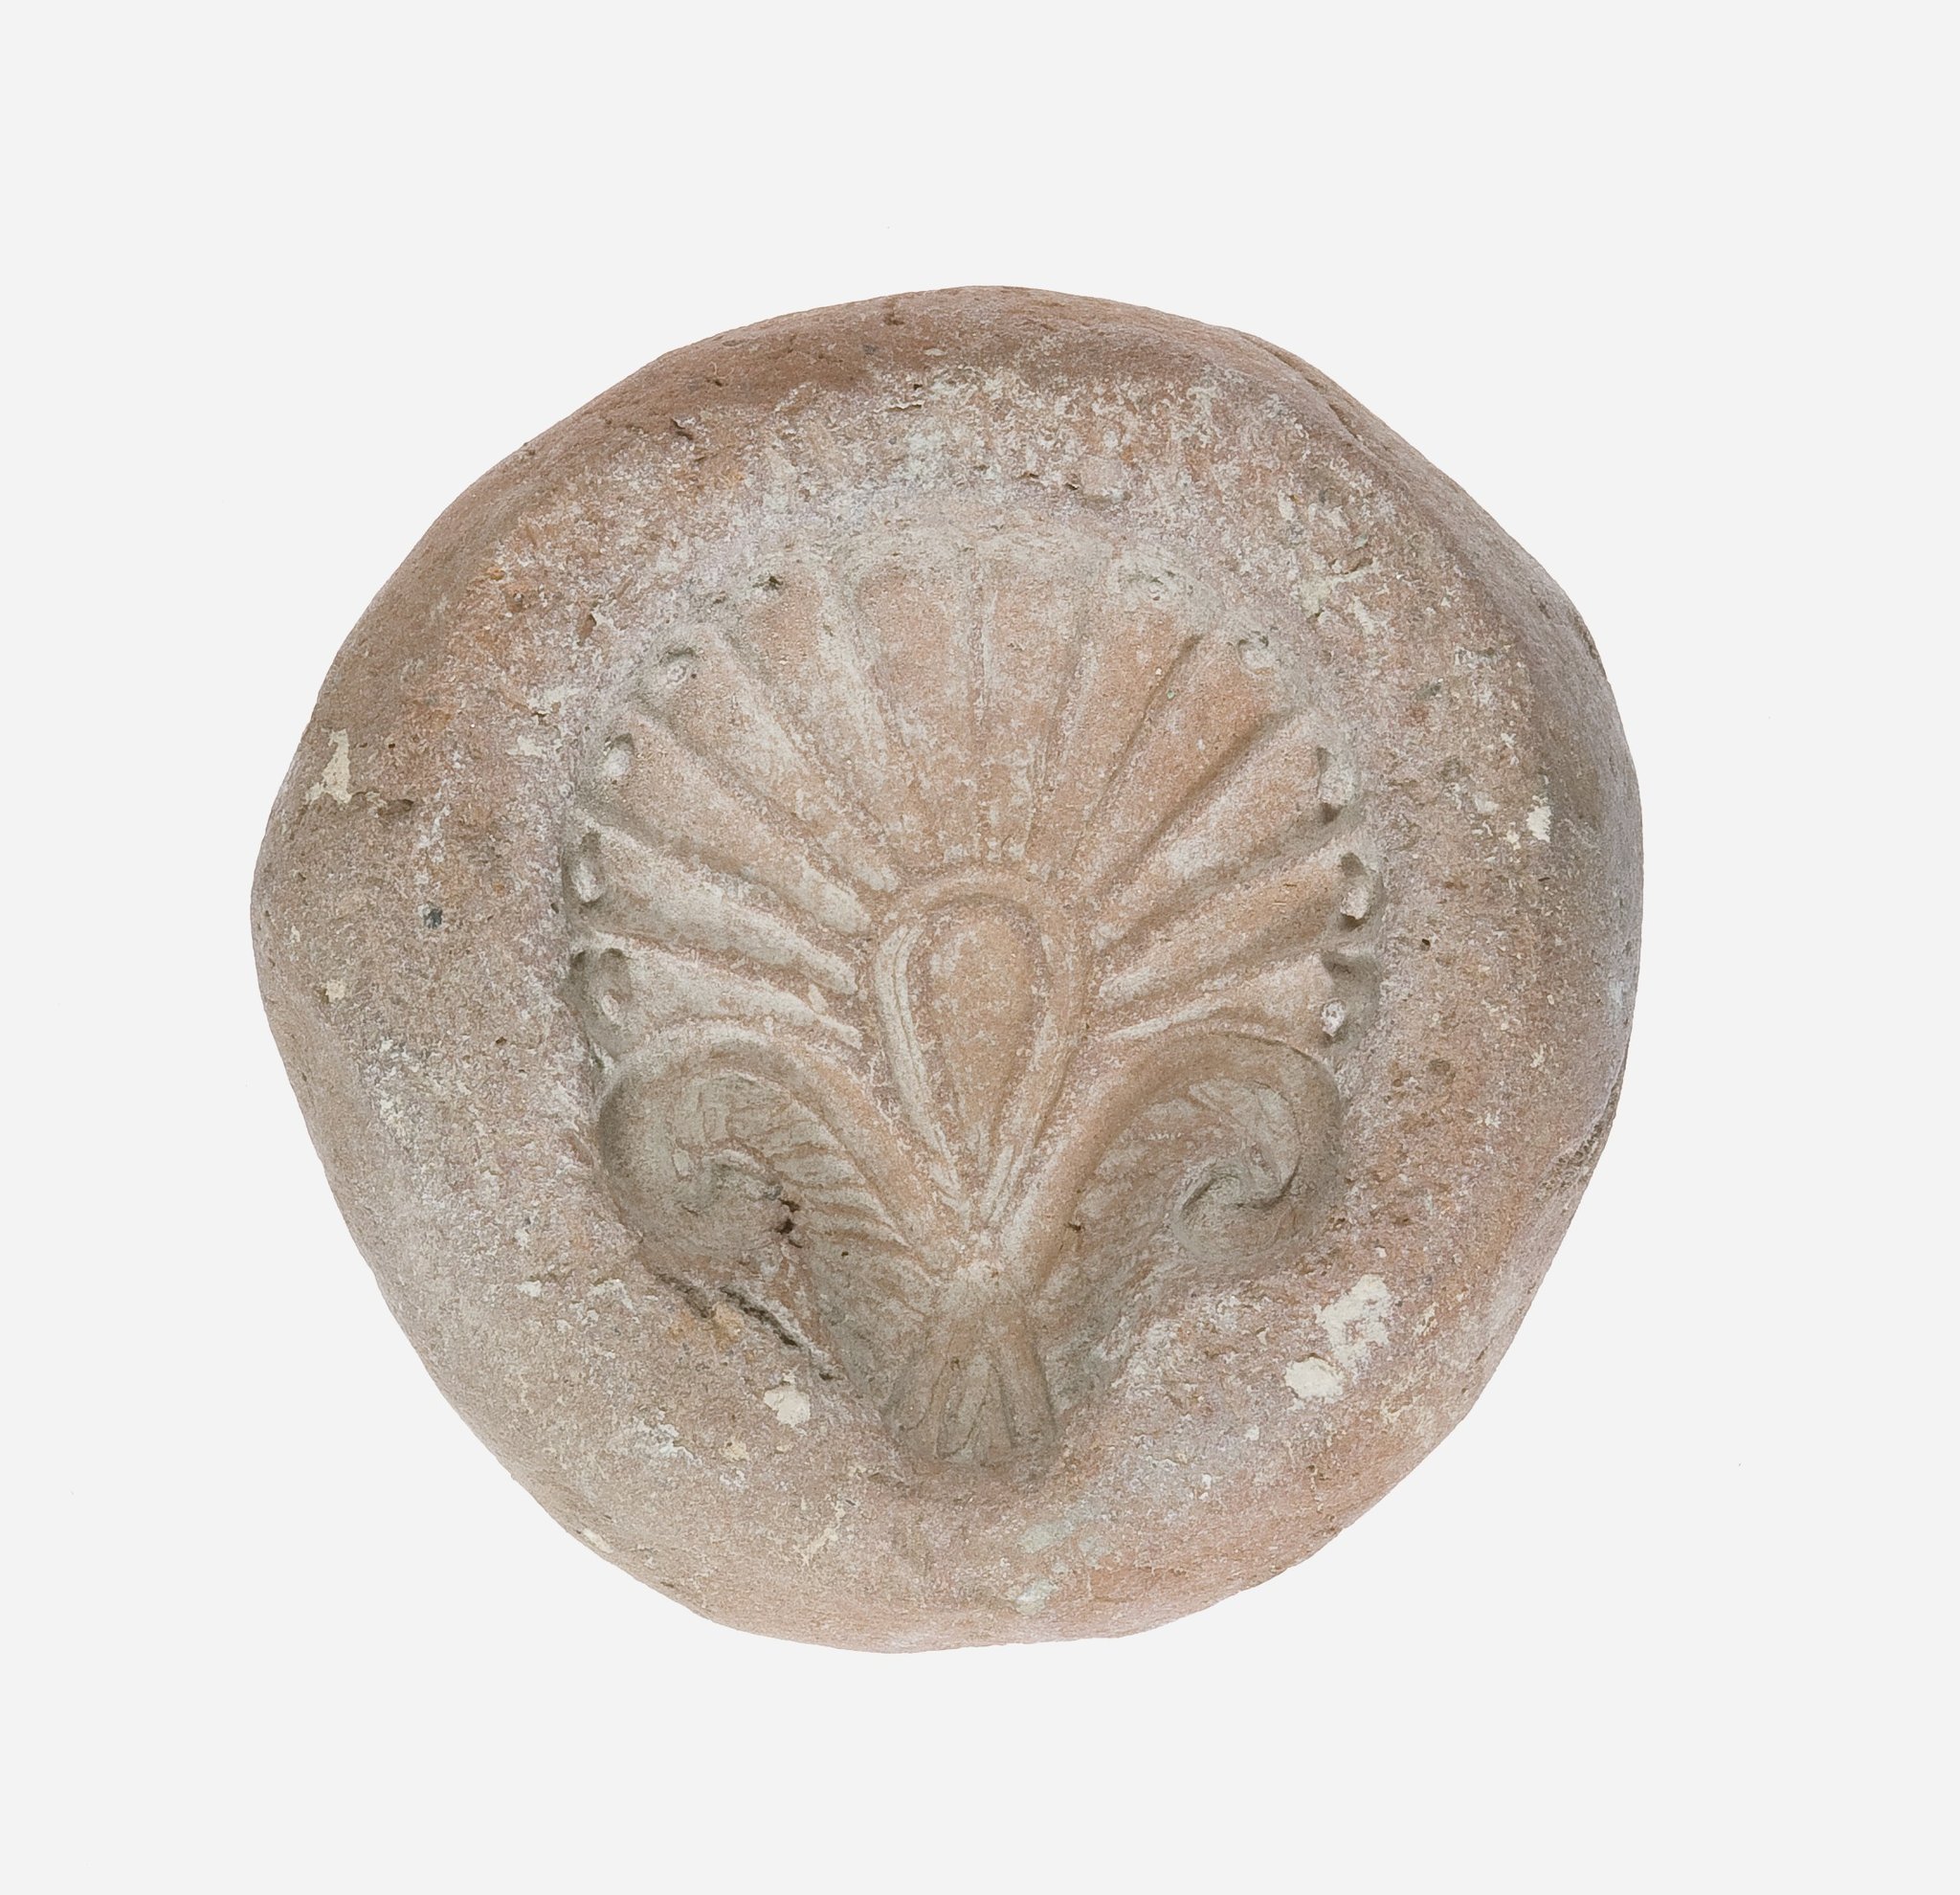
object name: mold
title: Palmette Mold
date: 1390-1352 BCE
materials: pottery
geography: egypt